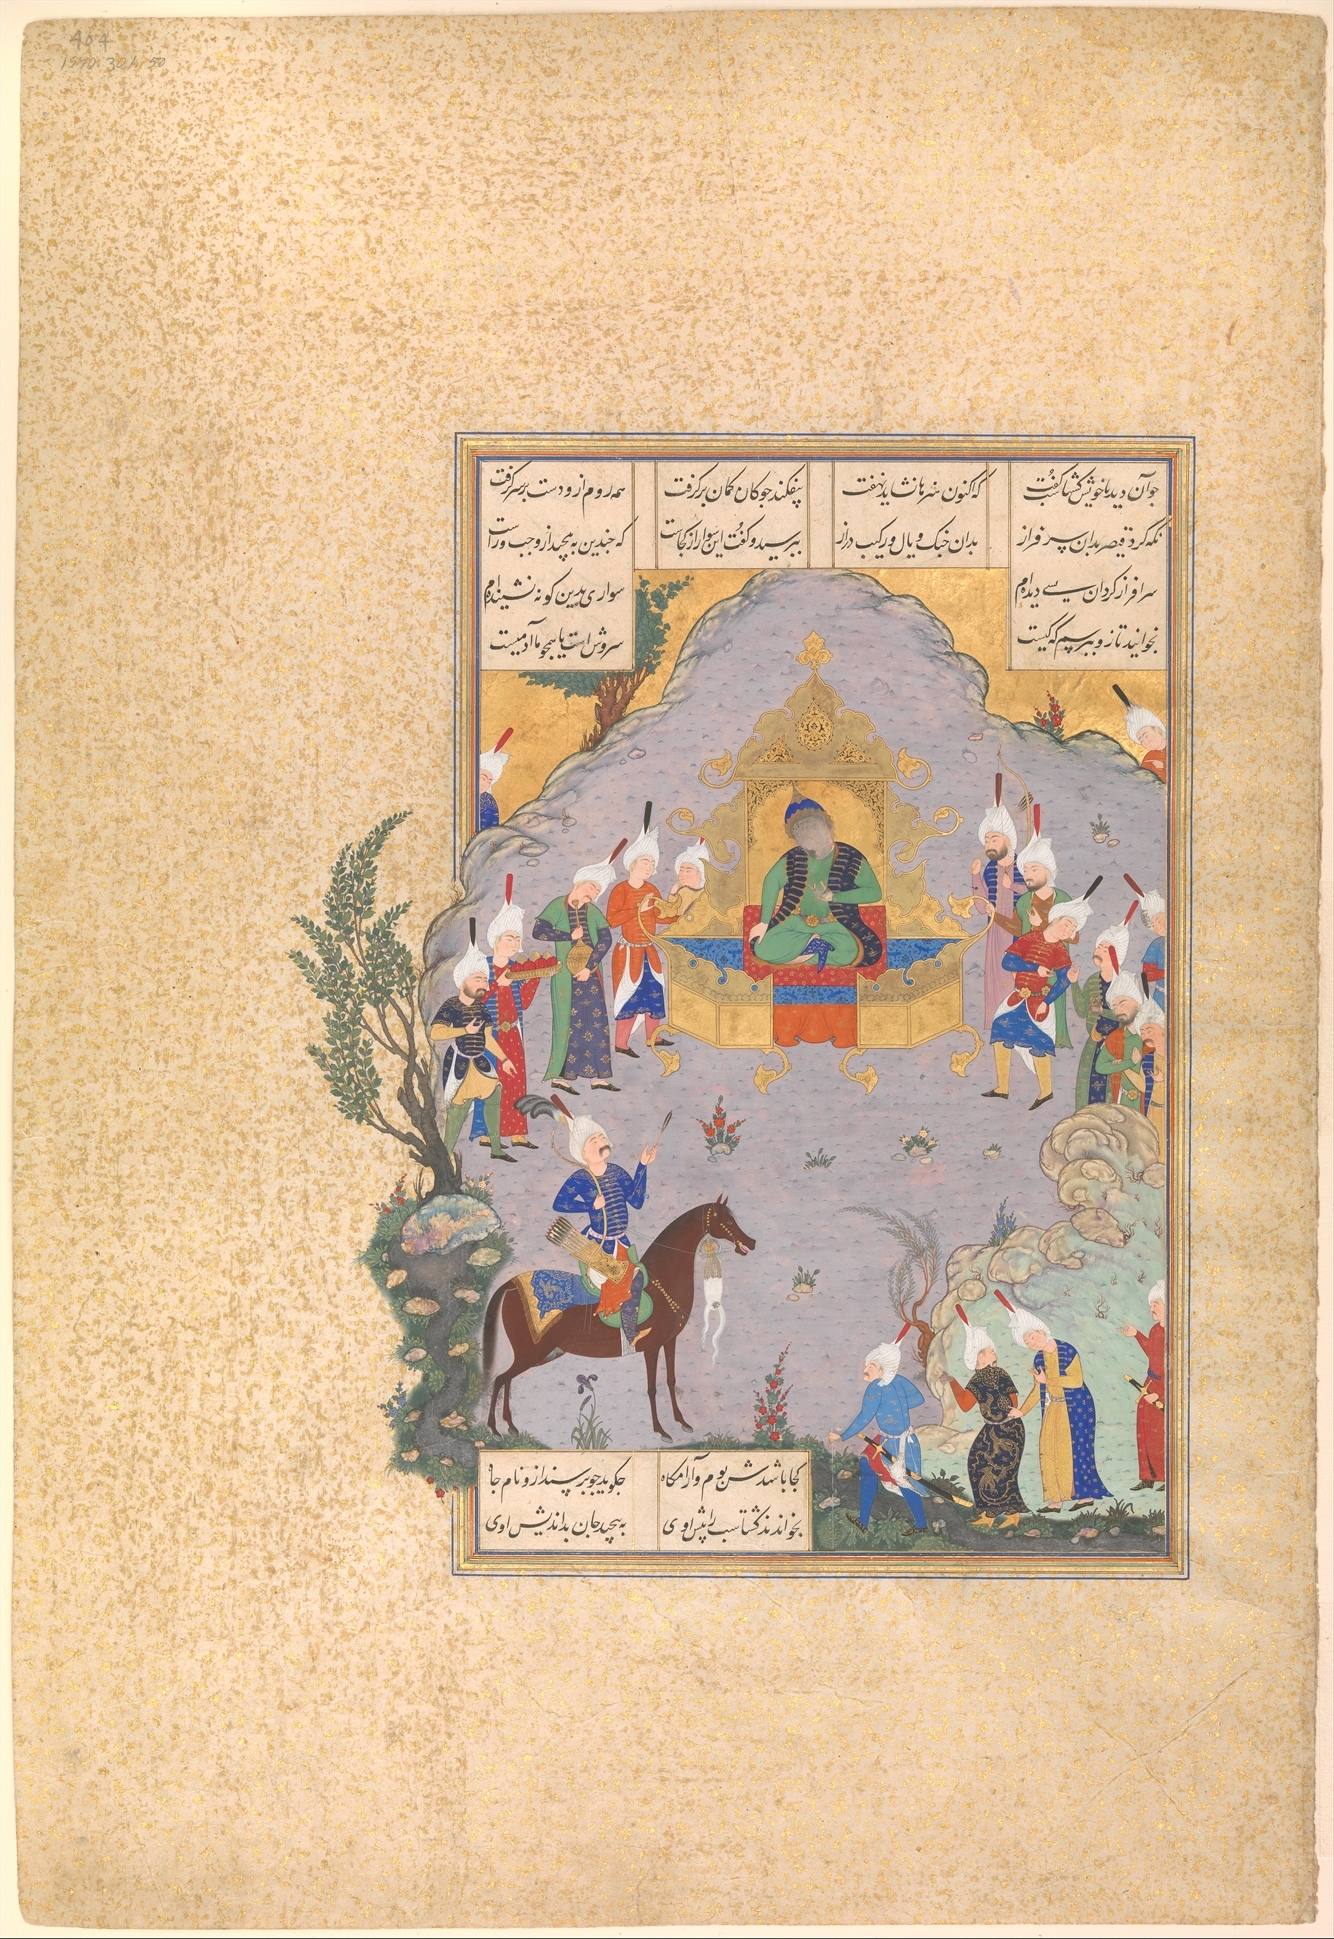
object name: folio from an illustrated manuscript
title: "Gushtasp Proves His Archery before Caesar," Folio 404r from the Shahnama (Book of Kings) of Shah Tahmasp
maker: abu'l qasim firdausi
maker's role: author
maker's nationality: iranian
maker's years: 935-1020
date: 1525-1530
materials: gold, ink, paper, silver, watercolor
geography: iran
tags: men,horses